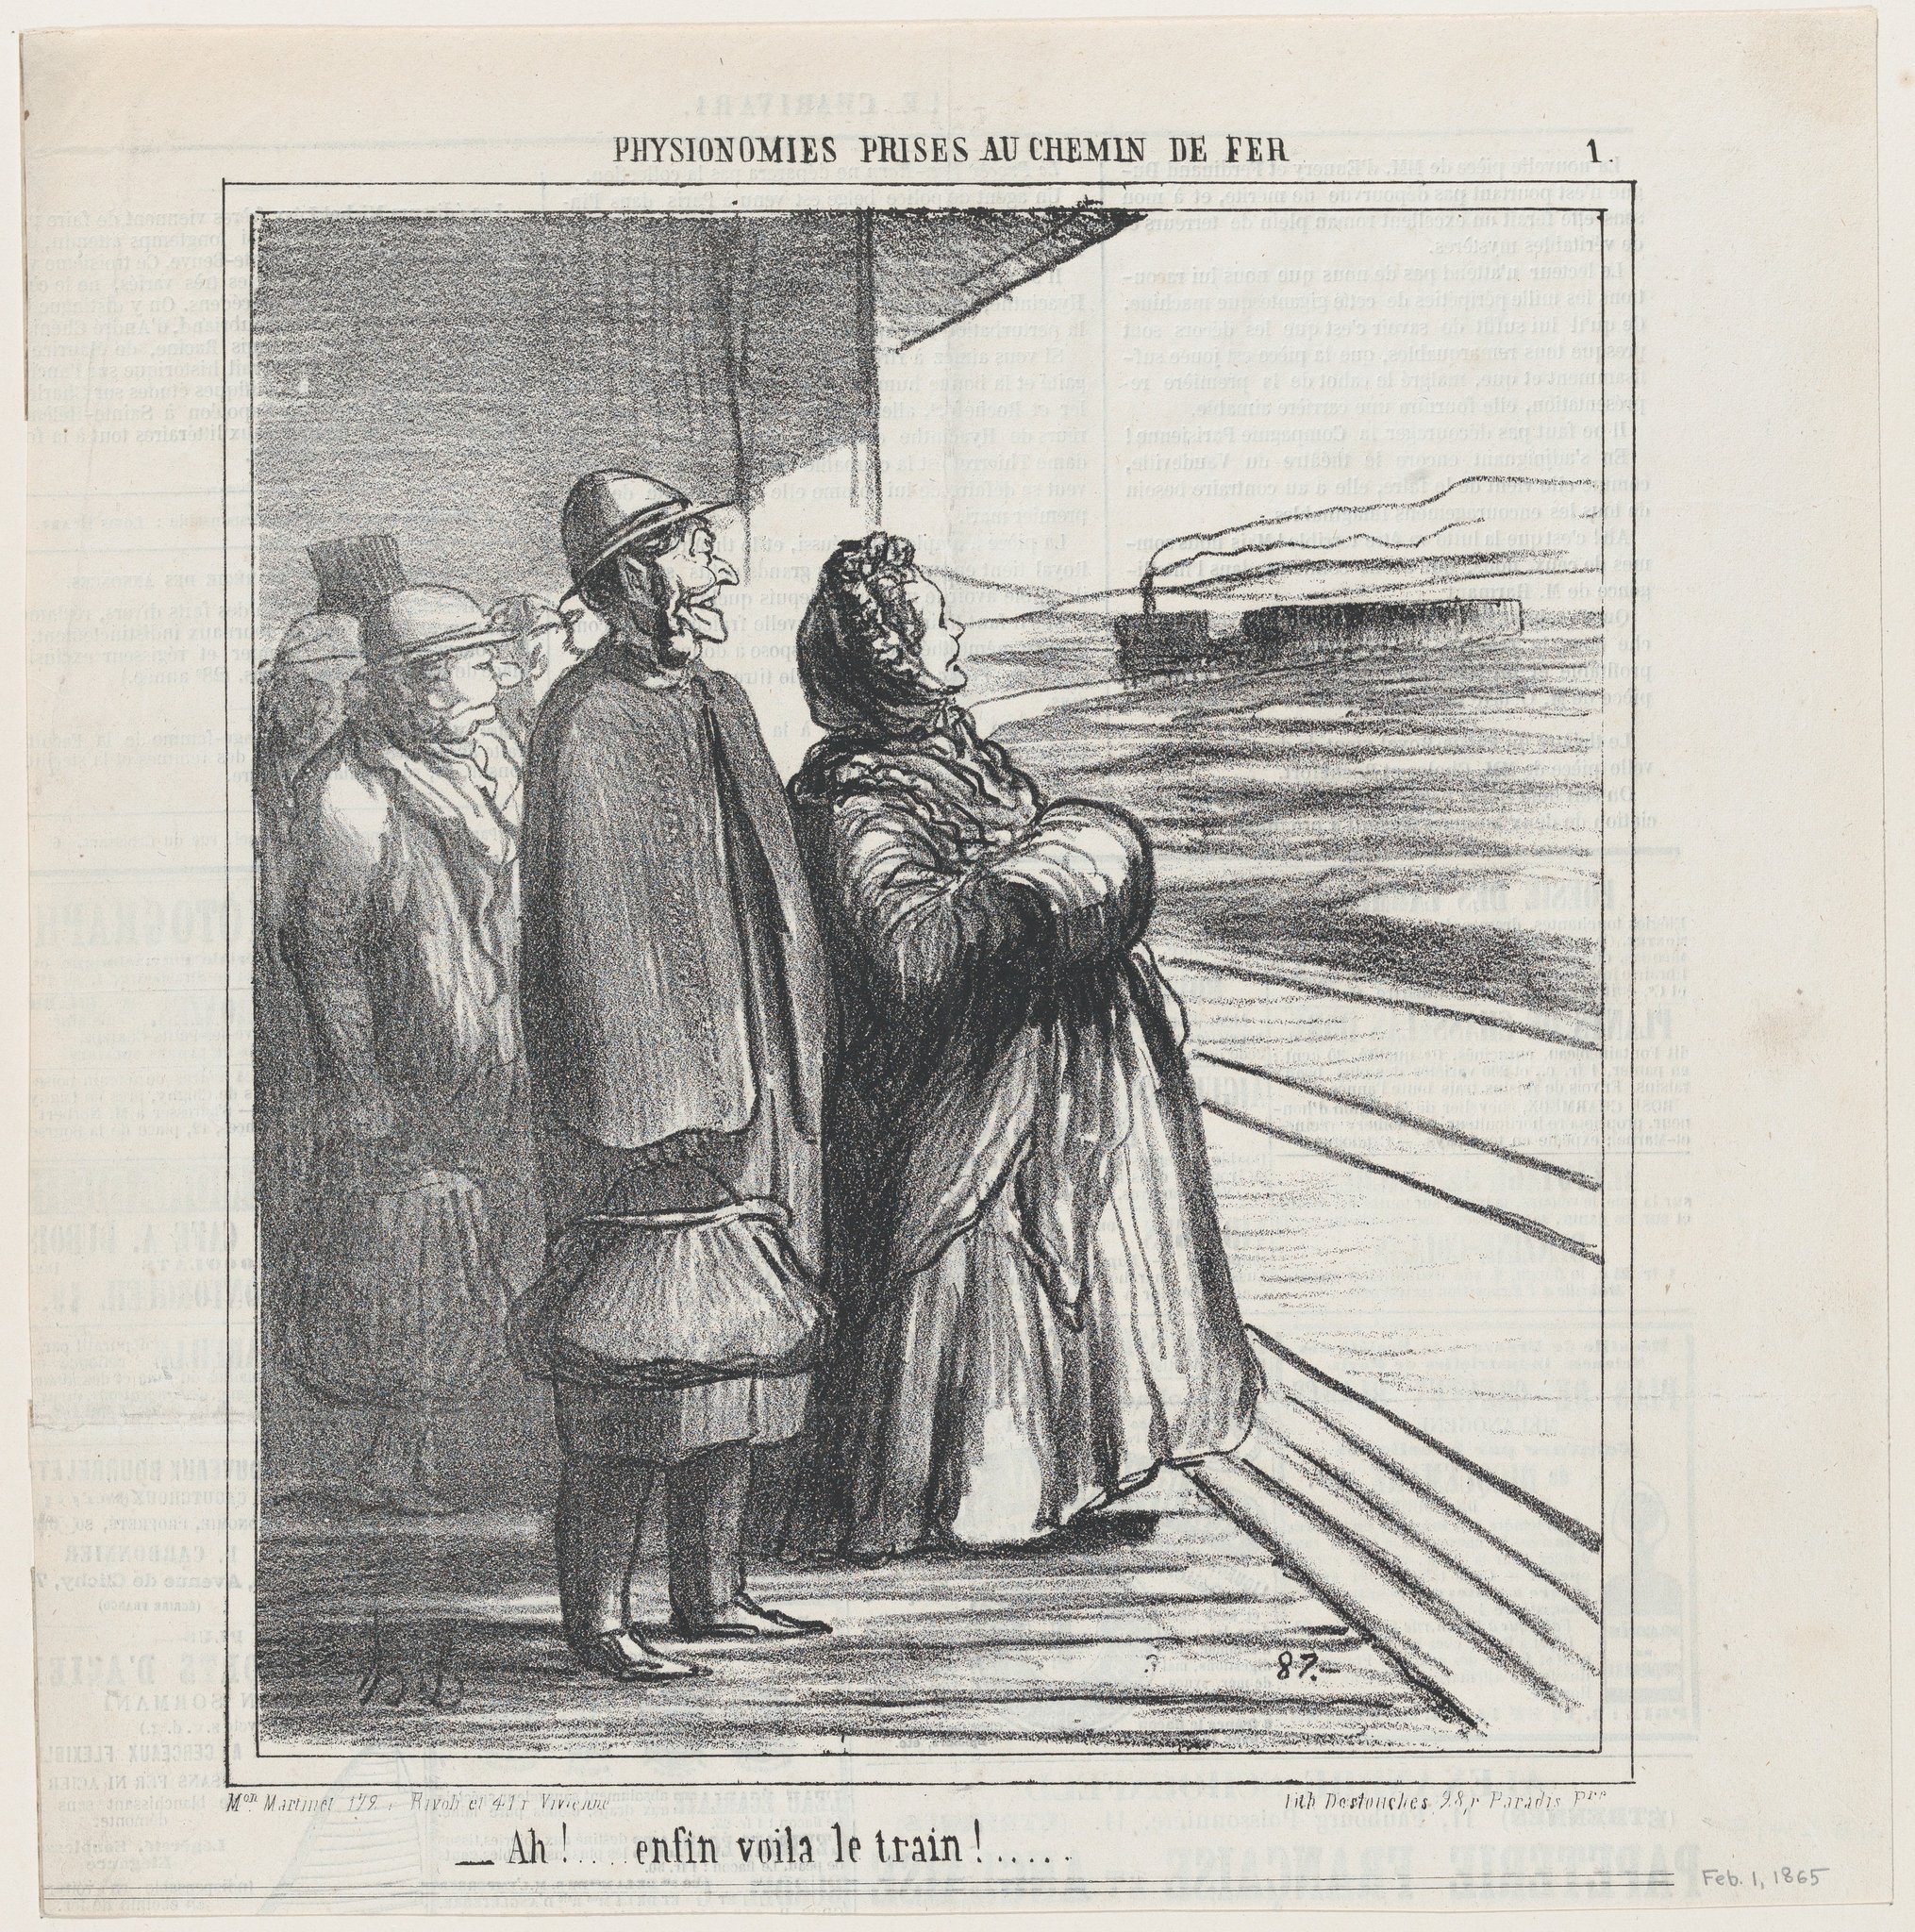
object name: print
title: Finally! Here comes the train, from 'People on the train,' published in Le Charivari, February 1, 1865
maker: honoré daumier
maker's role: artist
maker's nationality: french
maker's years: 1808-1879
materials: paper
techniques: lithograph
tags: railways,men,women,trains